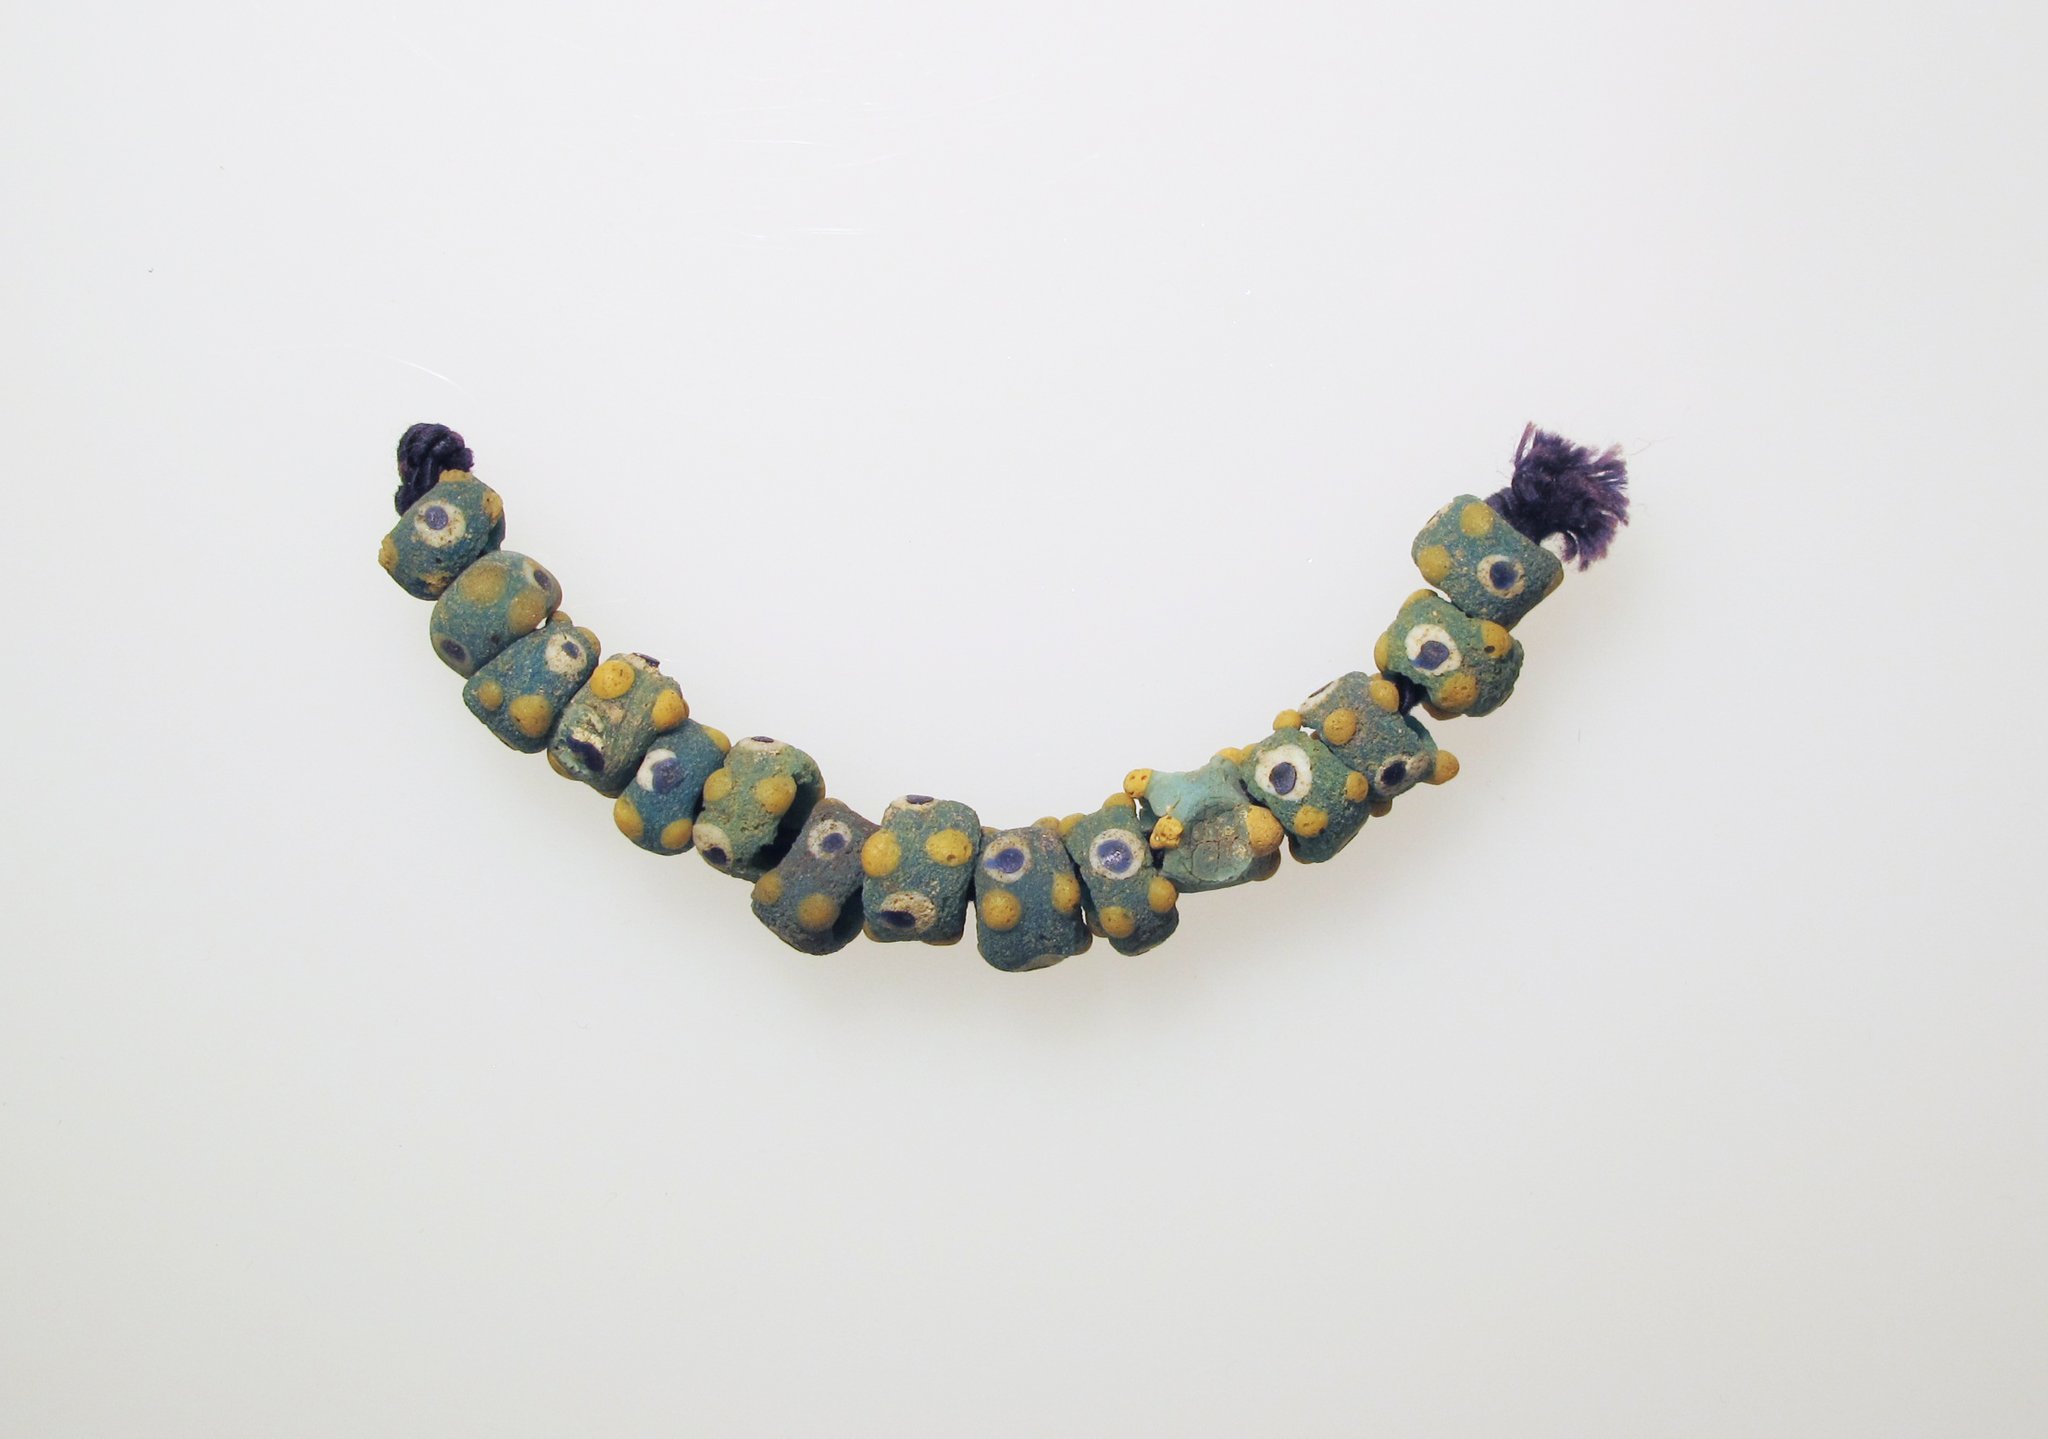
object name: bead, 16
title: Beads, 16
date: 7000 BCE-330 CE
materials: glass